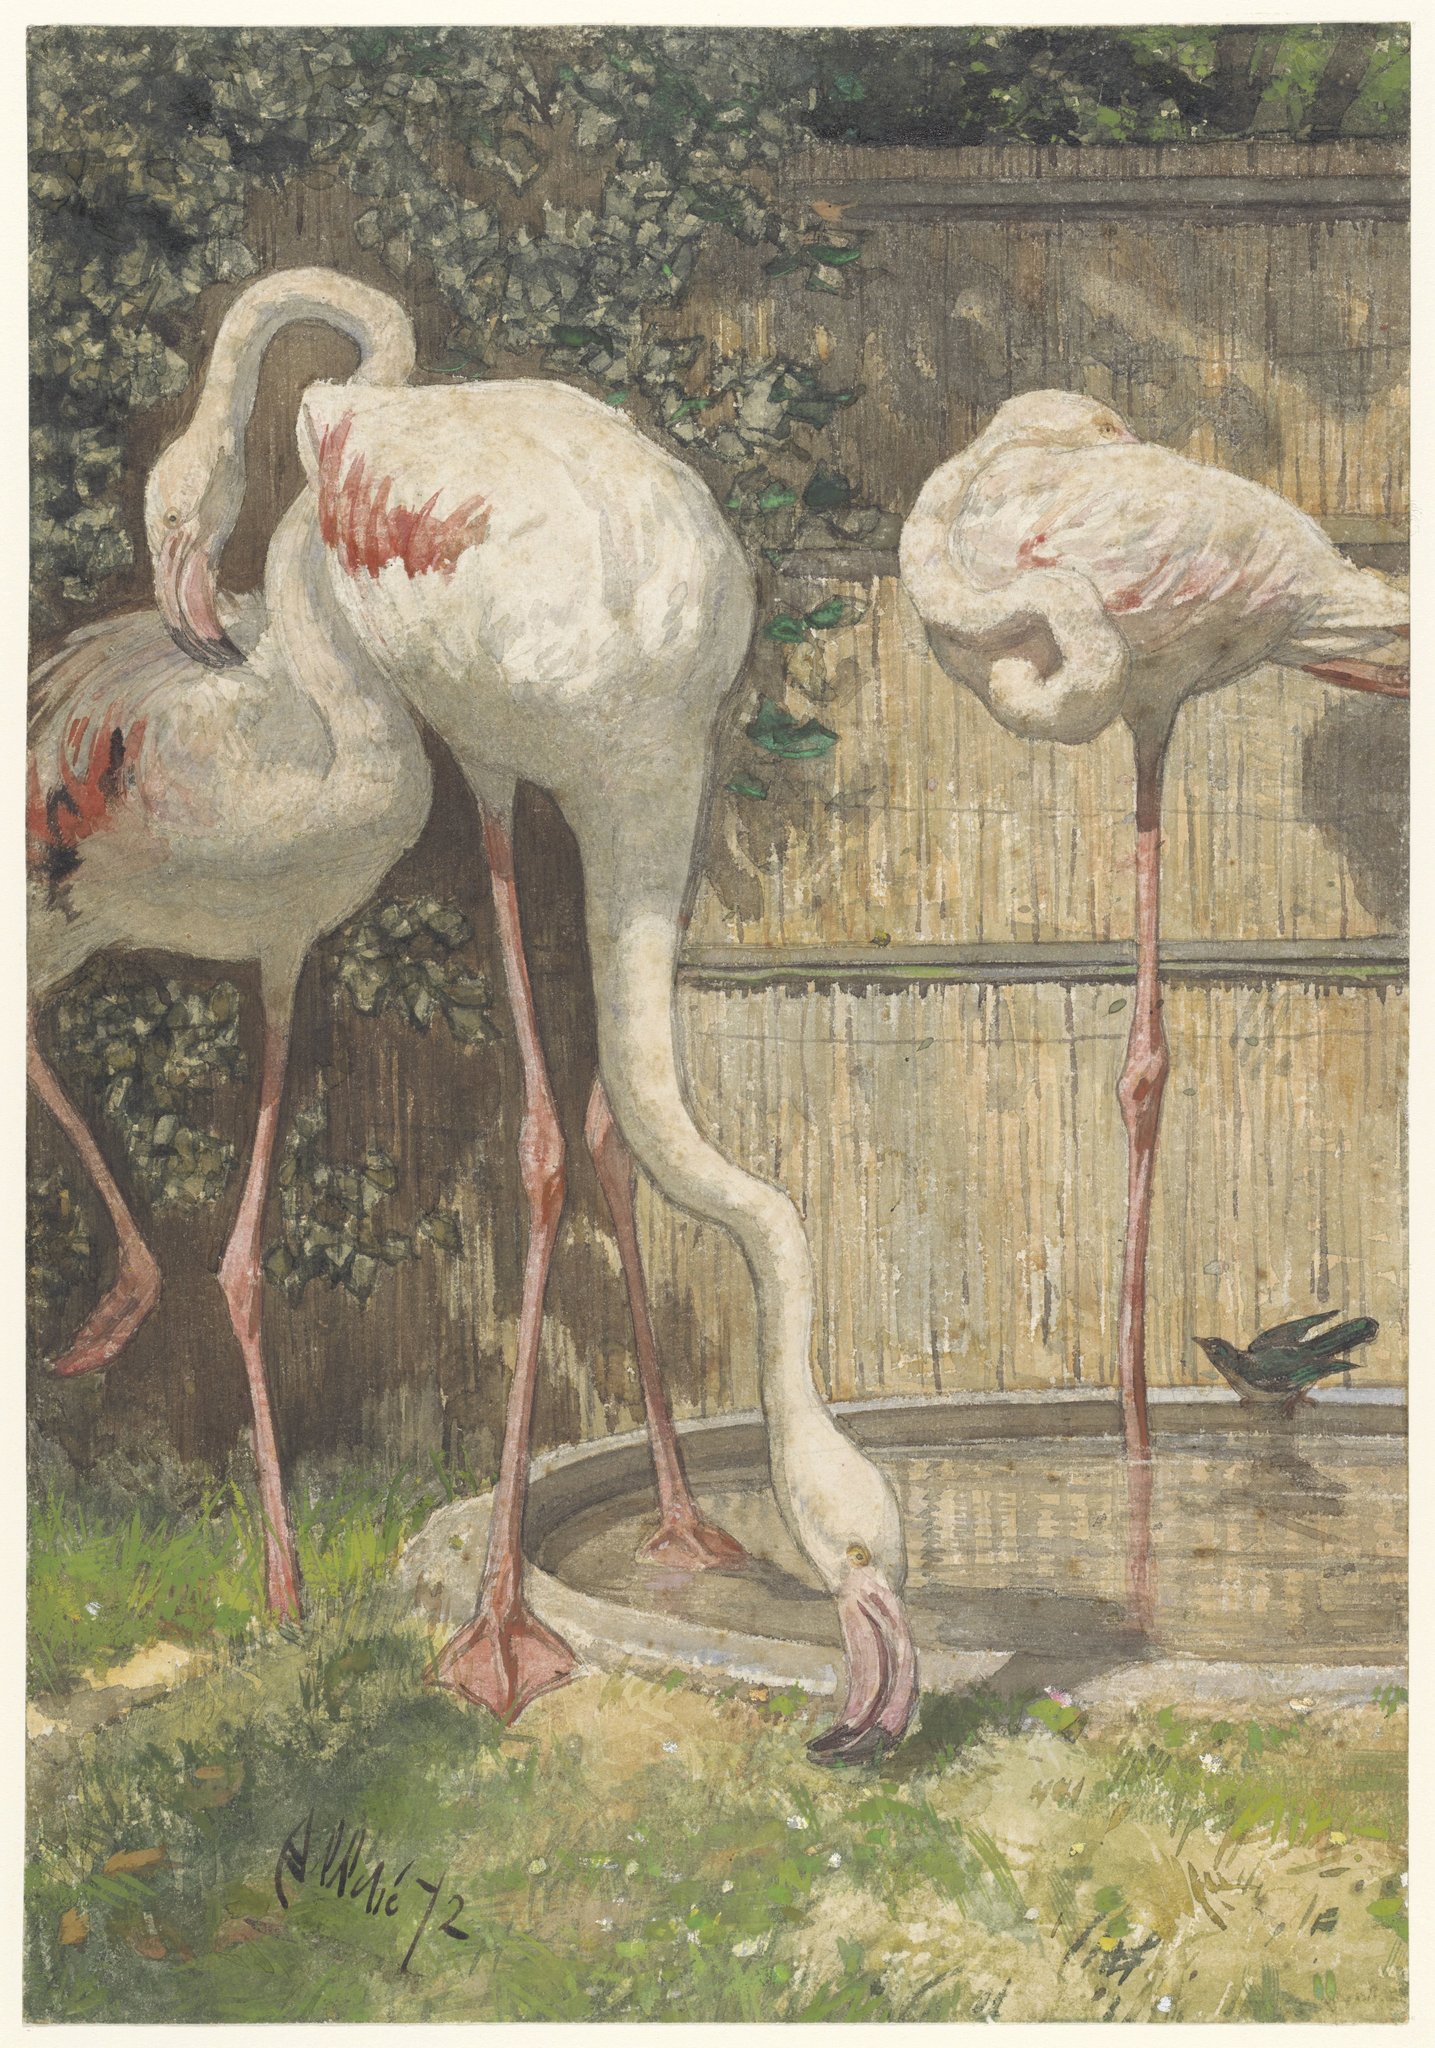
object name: drawing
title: Three Flamingos near a Basin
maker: august allebé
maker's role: draughtsman, print maker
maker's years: 1838-1927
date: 1872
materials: chalk, paper, watercolor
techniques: brush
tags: shore-birds and wading-birds: flamingo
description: August Allebé produced this worked-up drawing on the basis of sketches he had made on the spot in the zoo. He used a surprising palette of bright and natural colours. In his early work he favoured dark brown and red tints. Perhaps this change was brought about by all of the drawing he did out of doors.